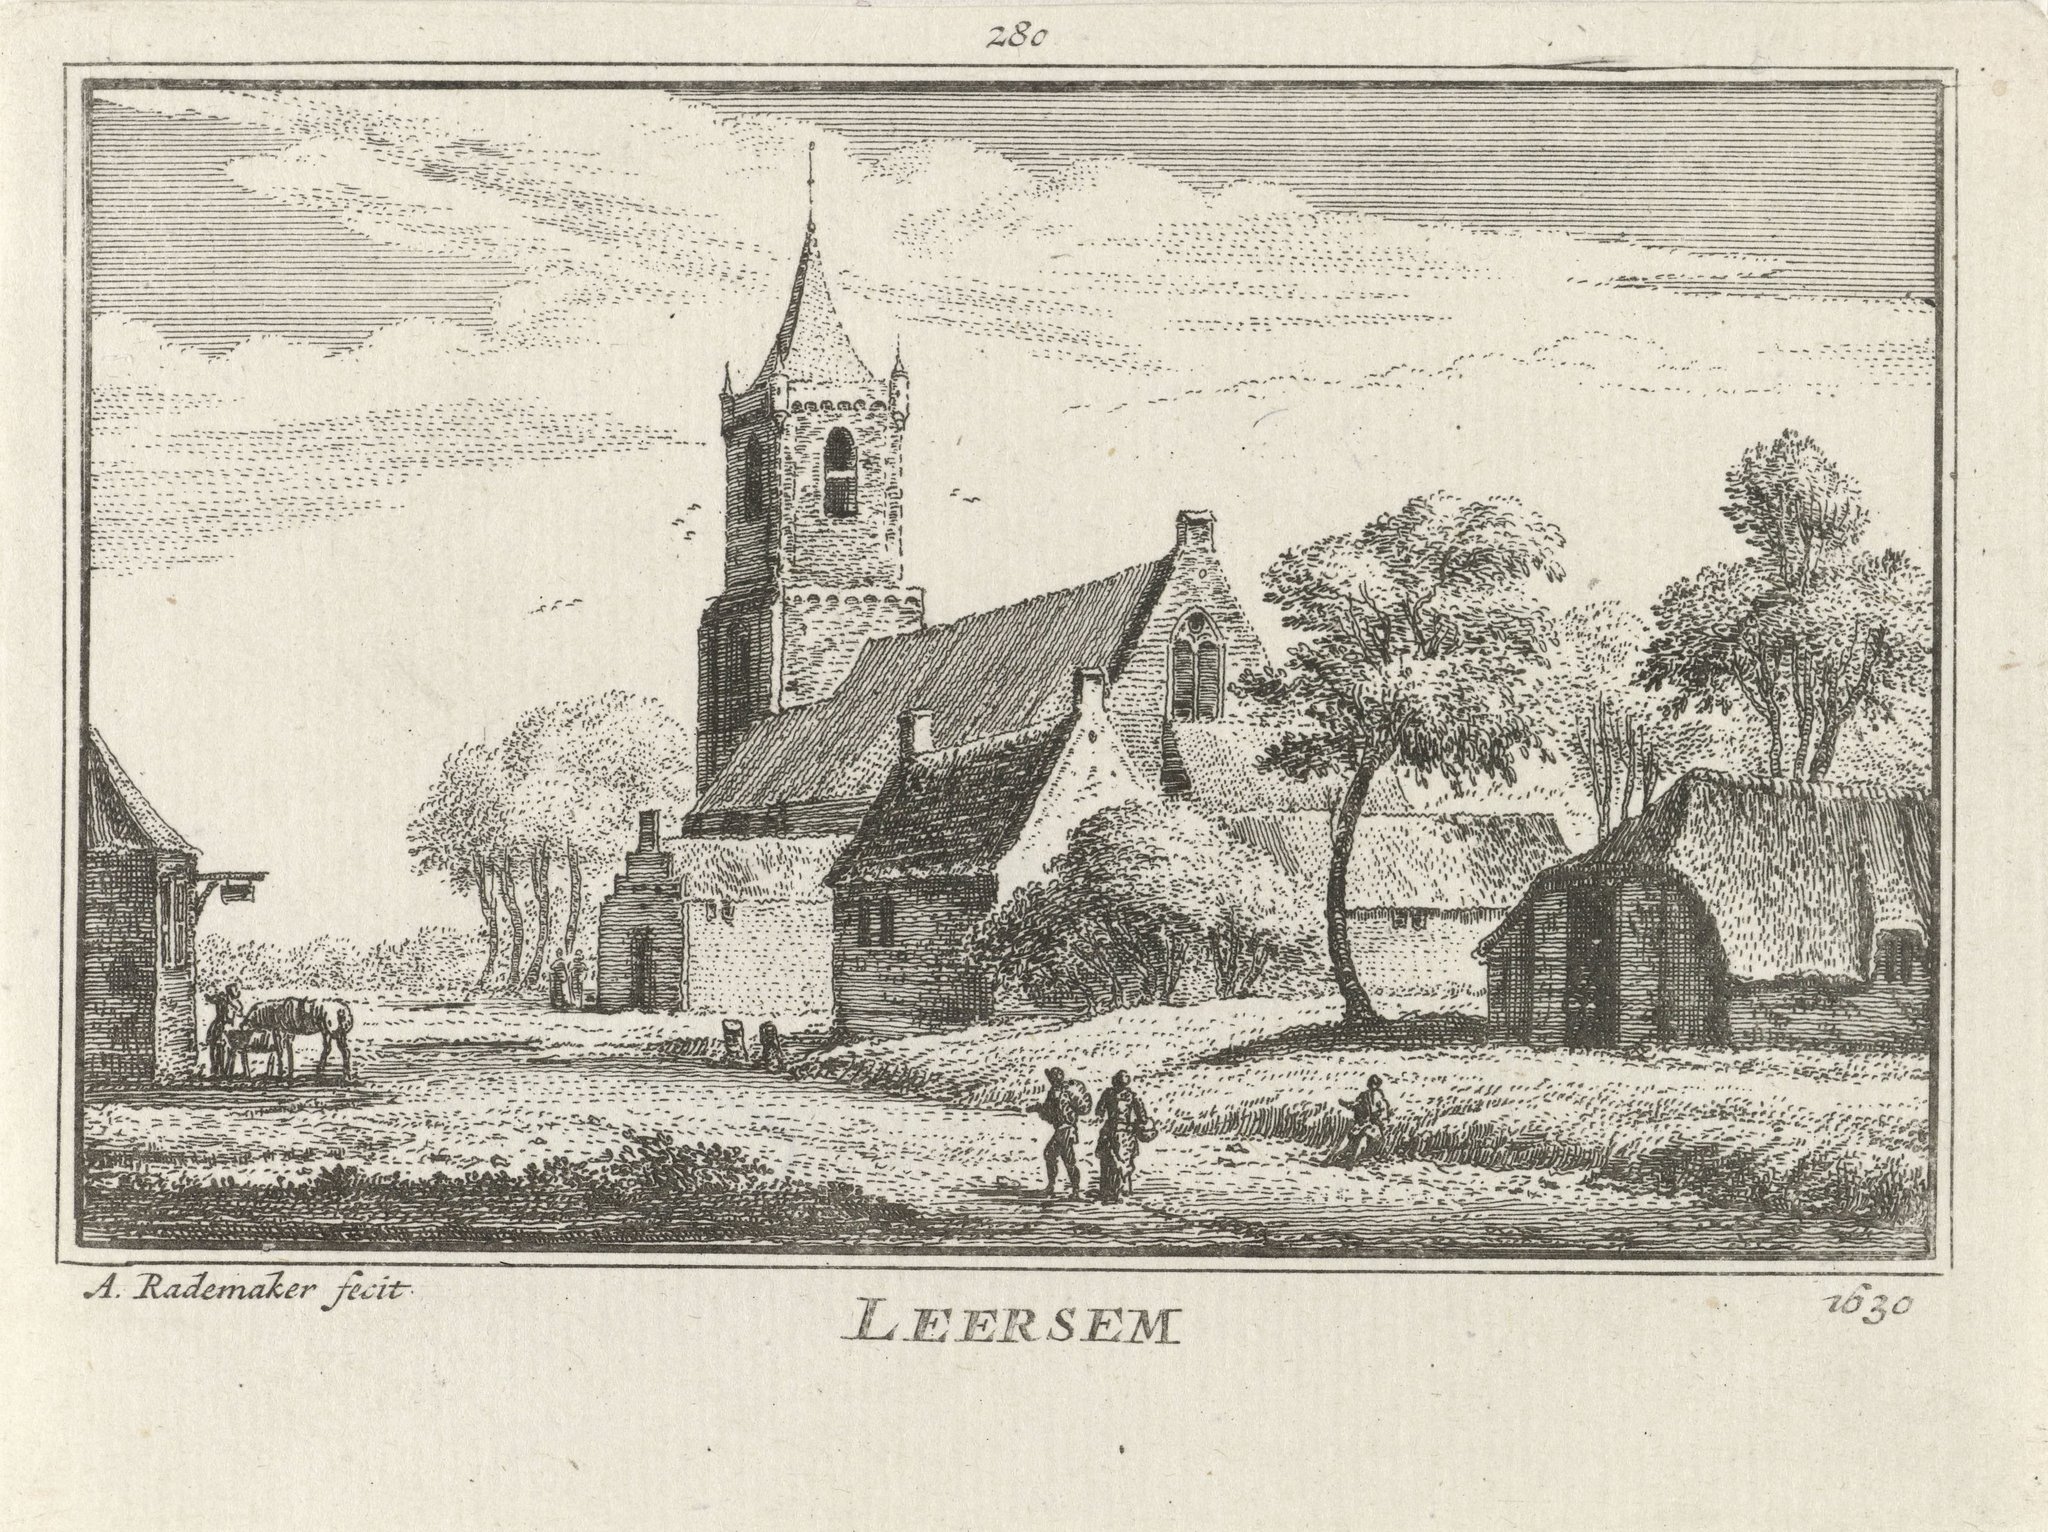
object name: print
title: Leersem 1630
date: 1727-1733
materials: paper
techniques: engraving, etching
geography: amsterdam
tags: church (exterior), horse, hotel, hostelry, inn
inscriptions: collector's mark: Lugt 2228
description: Illustratie uit: Abraham Rademaker, Matthaeus Brouërius van Niedek, Isaac Le Long, Kabinet van Nederlandsche en Kleefsche outheden en (...) voorname stads- en landgebouwen, Willem Barents en Antoni Schoonenburg: Amsterdam, 1727-1733, ill. nr. 280.